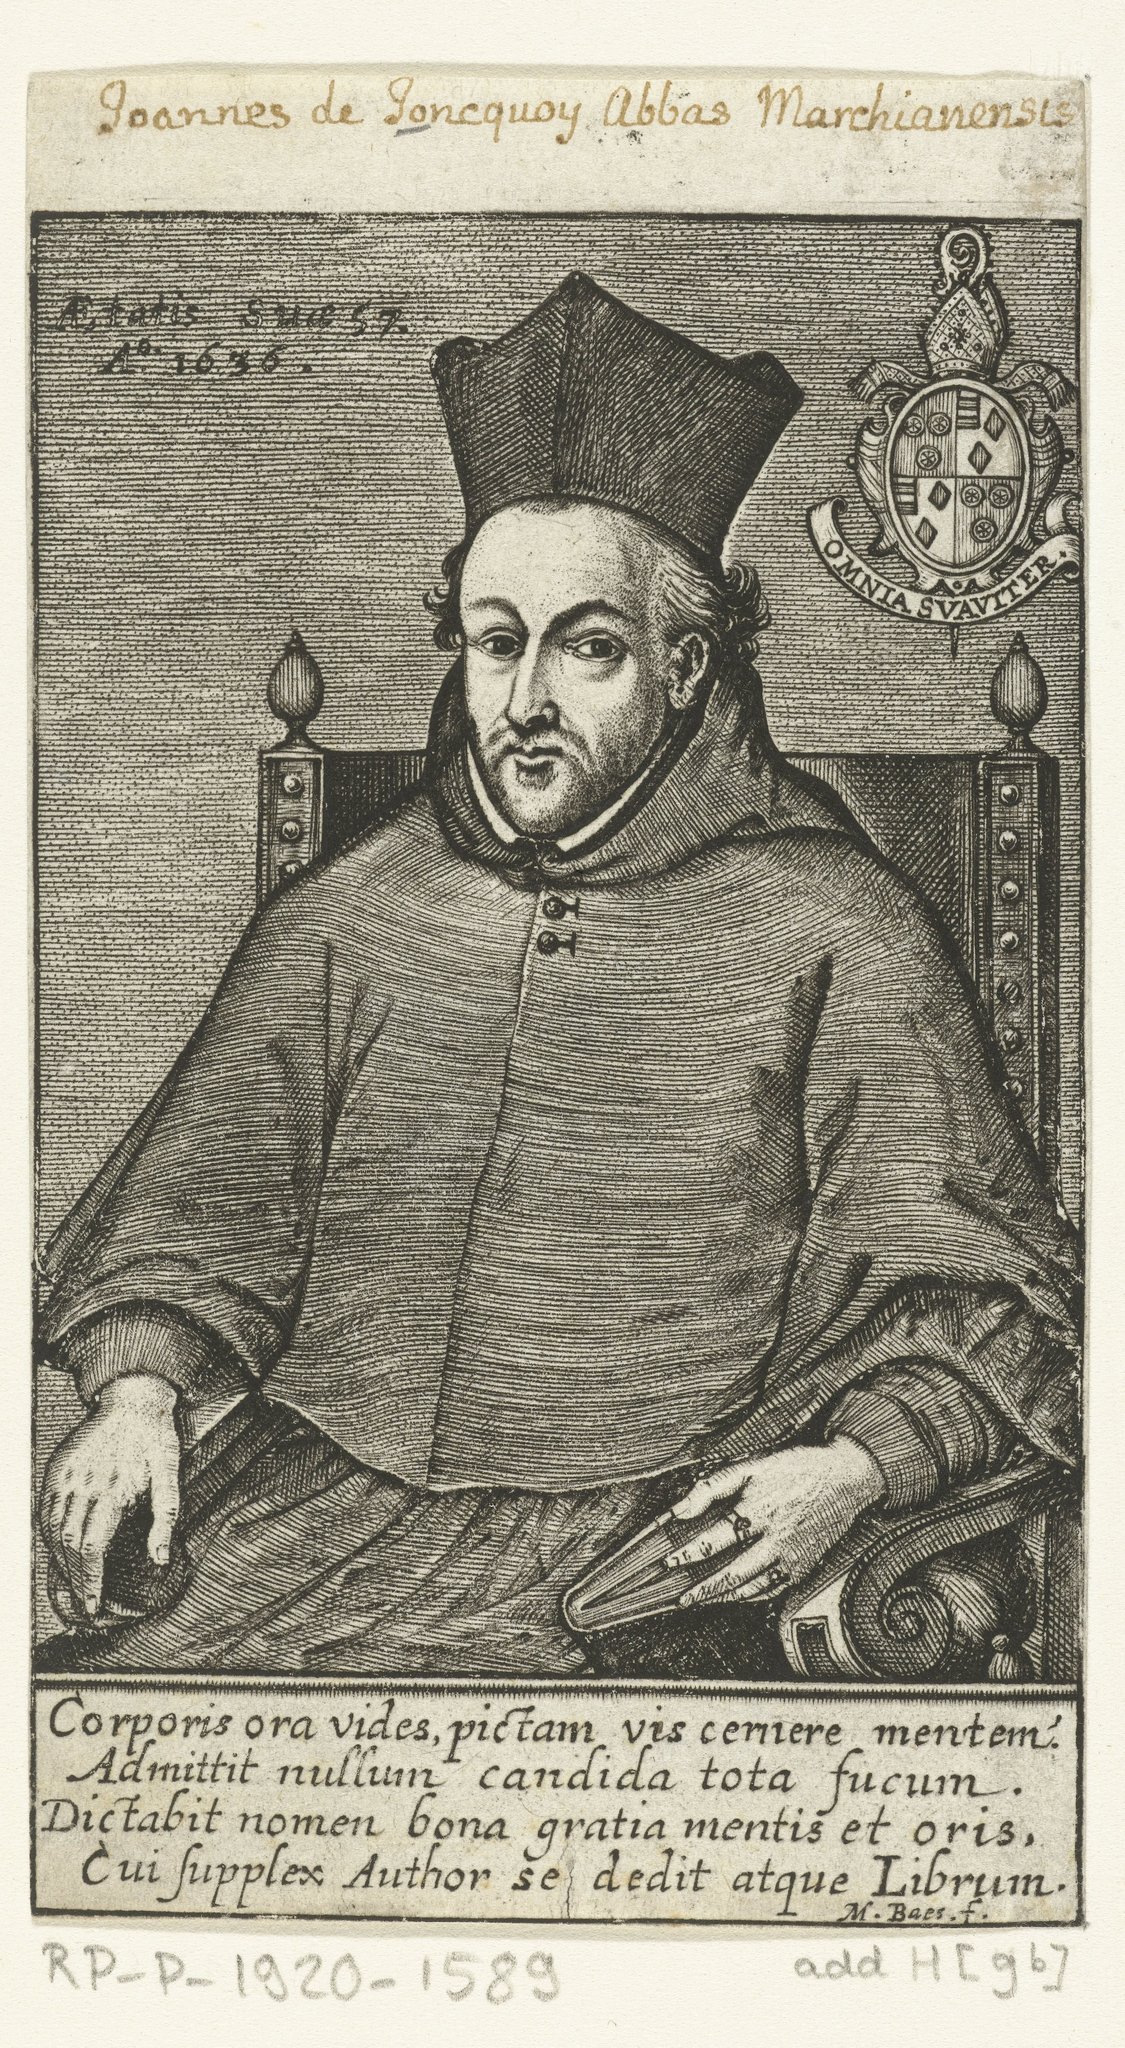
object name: print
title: Portret van Jean du Joncquoy op 57-jarige leeftijd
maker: martin baes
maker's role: print maker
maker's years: 1604-1637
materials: paper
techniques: engraving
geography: douai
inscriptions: inscription: ‘Joannes de Loncquoy abbas Marchianensis’, collector's mark: Lugt 2228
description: Portret van Jean du Joncquoy op 57-jarige leeftijd. Onder het portret een vers in het Latijn van vier regels.